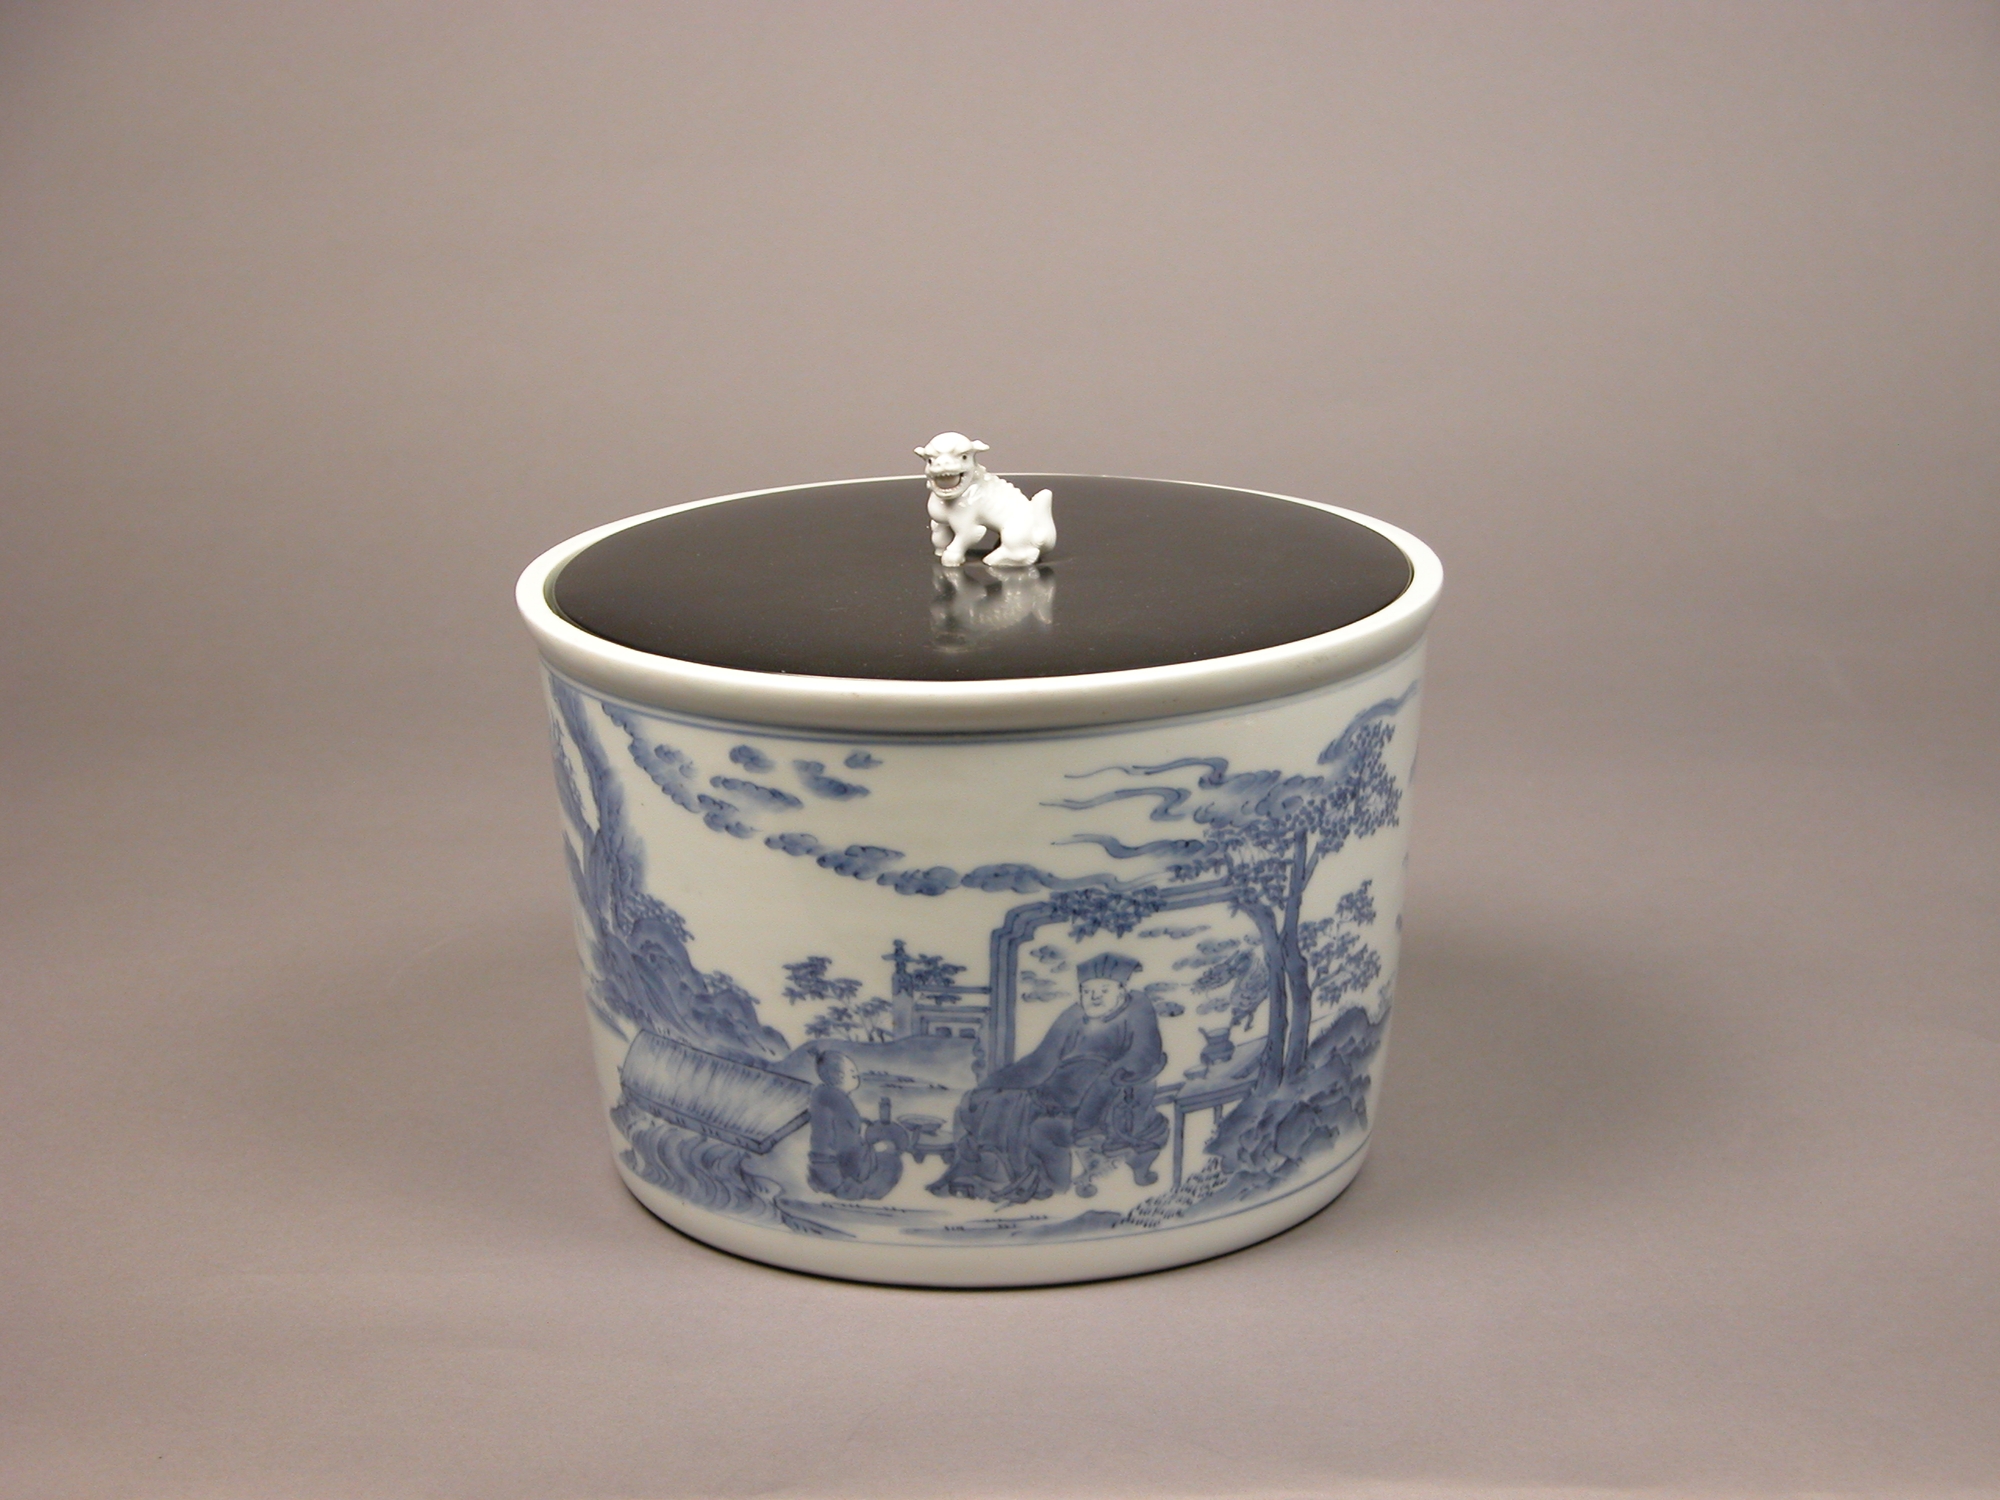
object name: water jar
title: Water Jar with Chinese Scholars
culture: japanese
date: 1701-1750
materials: lacquer, porcelain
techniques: underglaze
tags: animals,boys,men,trees